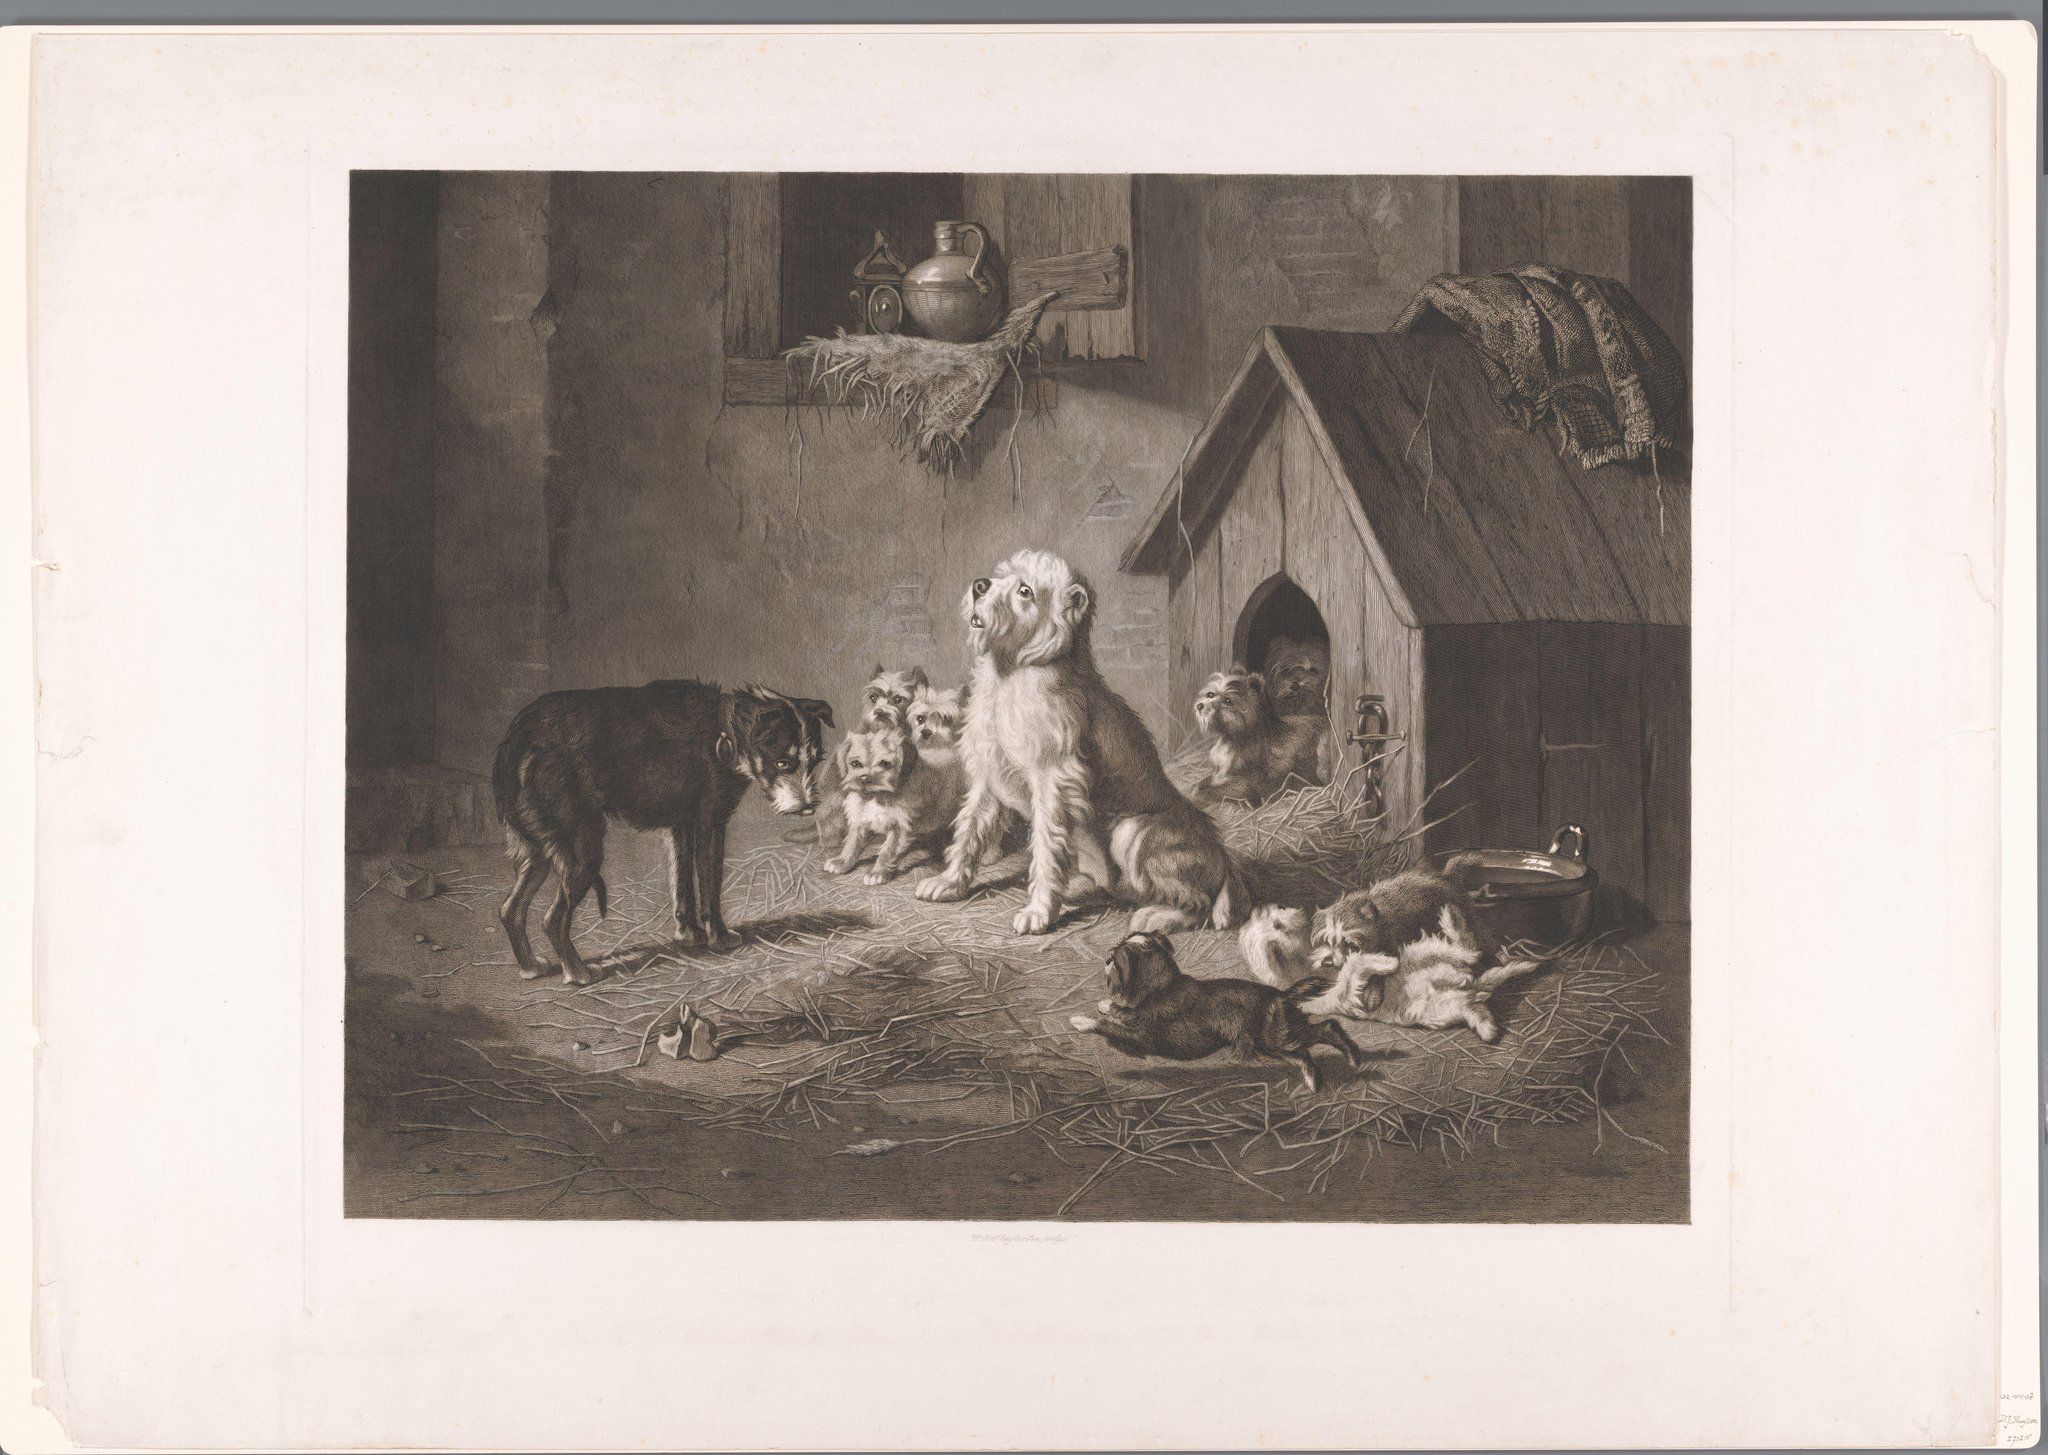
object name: print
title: Tien honden in en voor een hondenhok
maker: dirk jurriaan sluyter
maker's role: draughtsman, print maker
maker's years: 1811-1886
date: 1821-1886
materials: paper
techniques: engraving, etching, intaglio, retroussage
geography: amsterdam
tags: dog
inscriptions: collector's mark: Lugt 2166